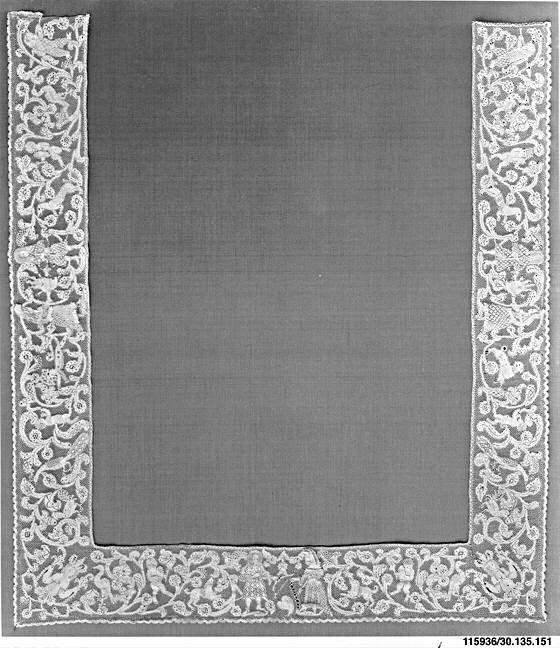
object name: border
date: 1601-1700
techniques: lace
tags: men,women